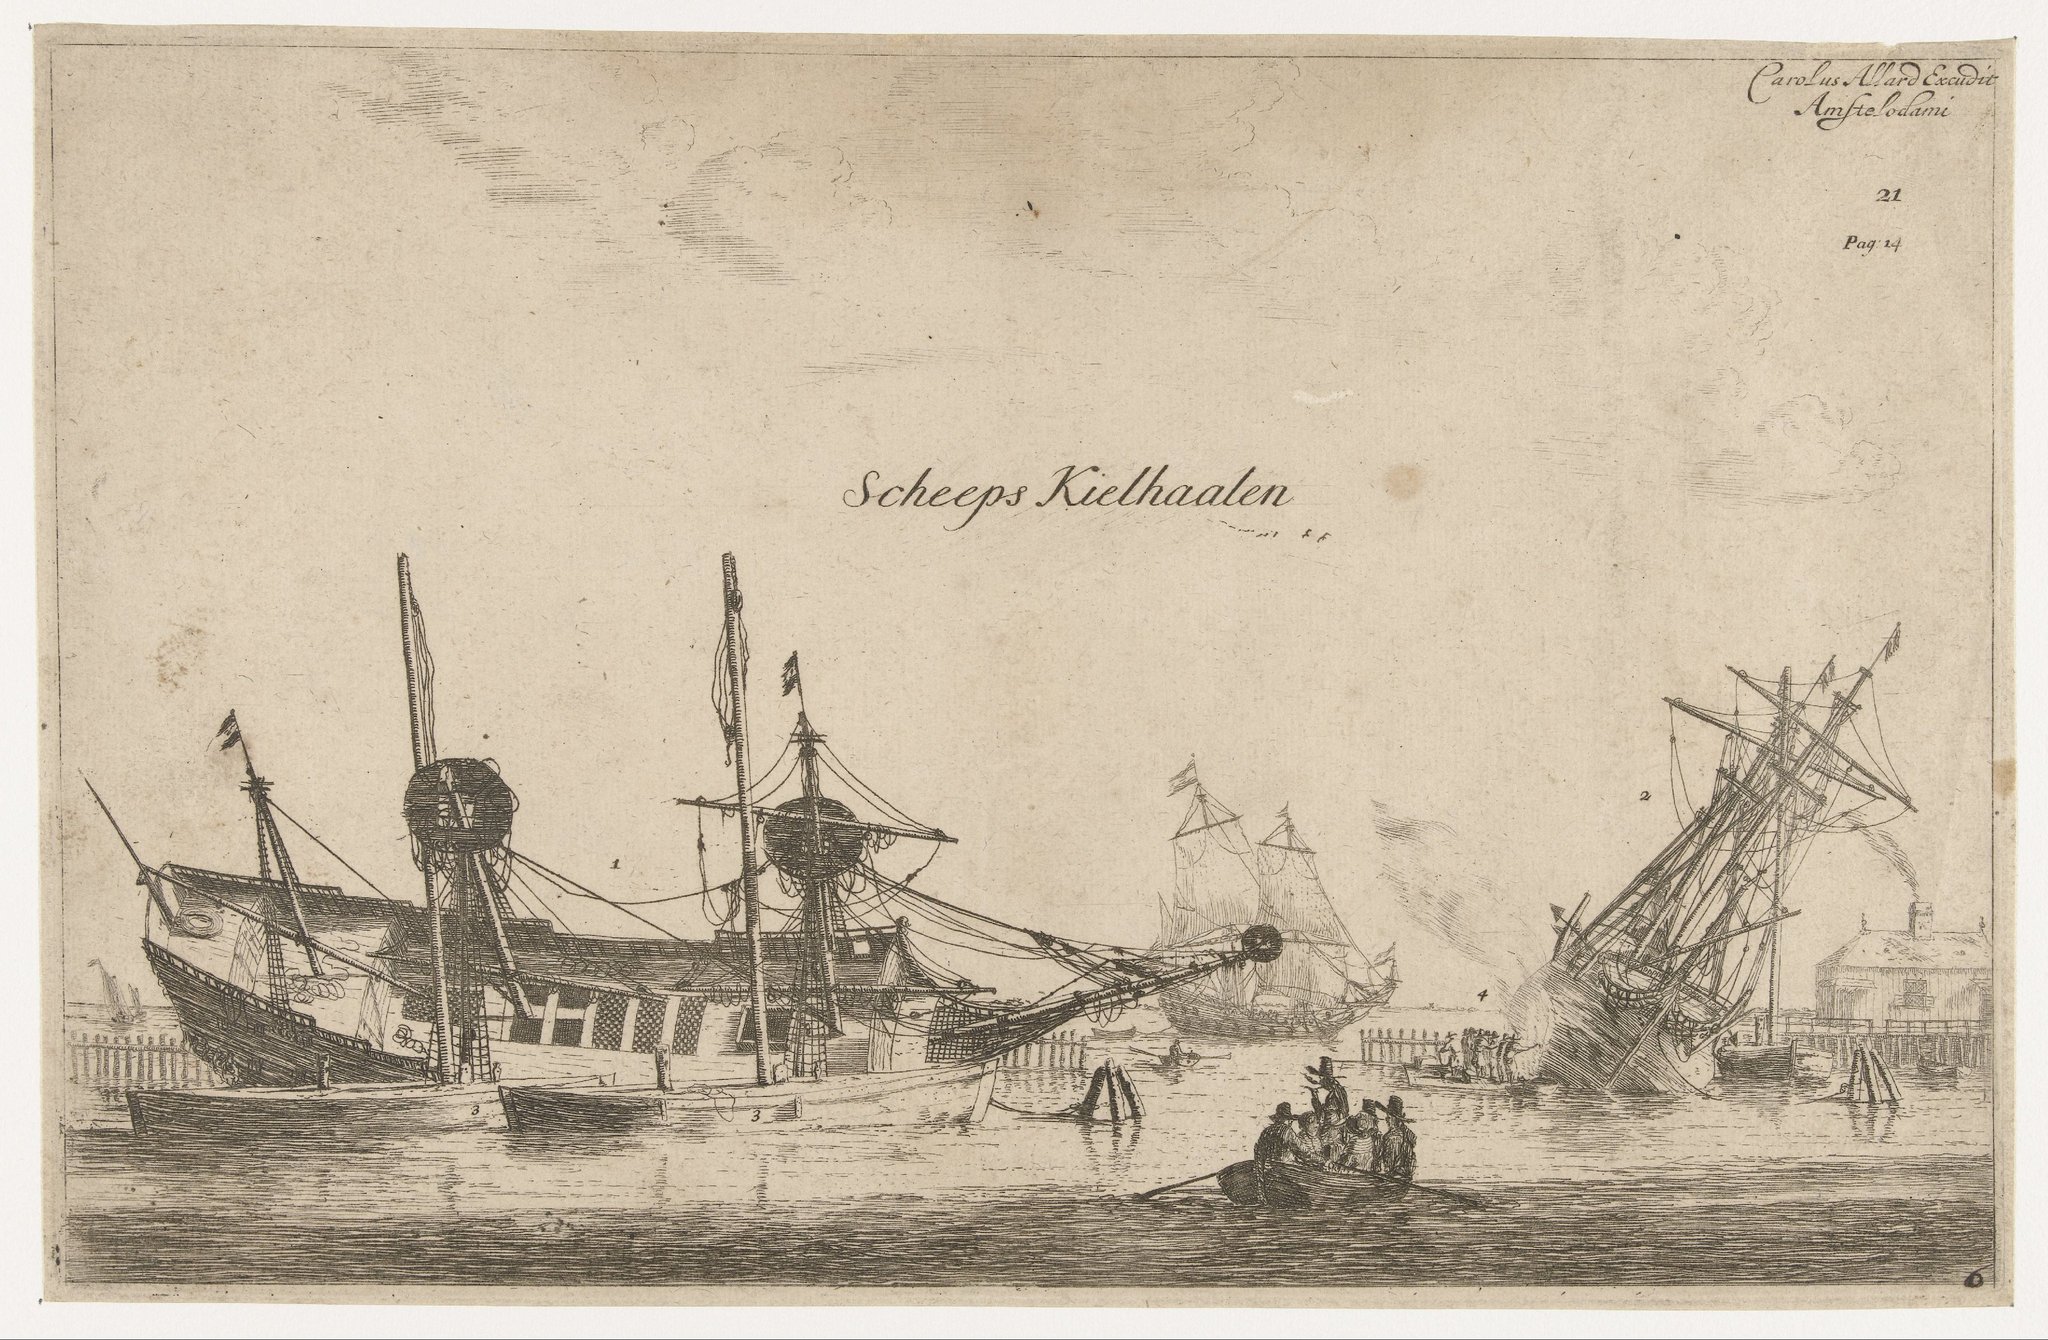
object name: print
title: Twee gekielde zeilschepen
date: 1650-1716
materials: paper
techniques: etching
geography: amsterdam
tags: repairing, caulking, careening (~ ship)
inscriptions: inscription: ‘Pag. 14’, number: ‘6’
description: Een werf met twee onderleggers die een groot zeilschip kielen, een gekield schip met mannen die werken aan het waterdichtmaken van de romp en een roeiboot met een aantal mensen erin. Buiten de golfbreker nog een aantal zeilschepen op het water.